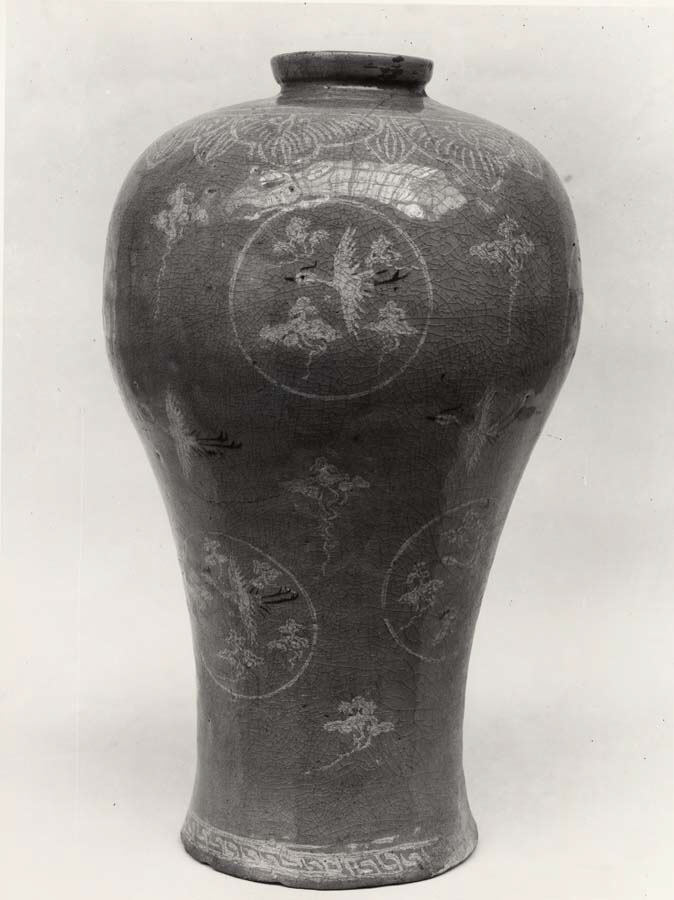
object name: jar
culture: korean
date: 1901-1933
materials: ceramic glaze, glaze, stoneware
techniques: inlay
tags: birds